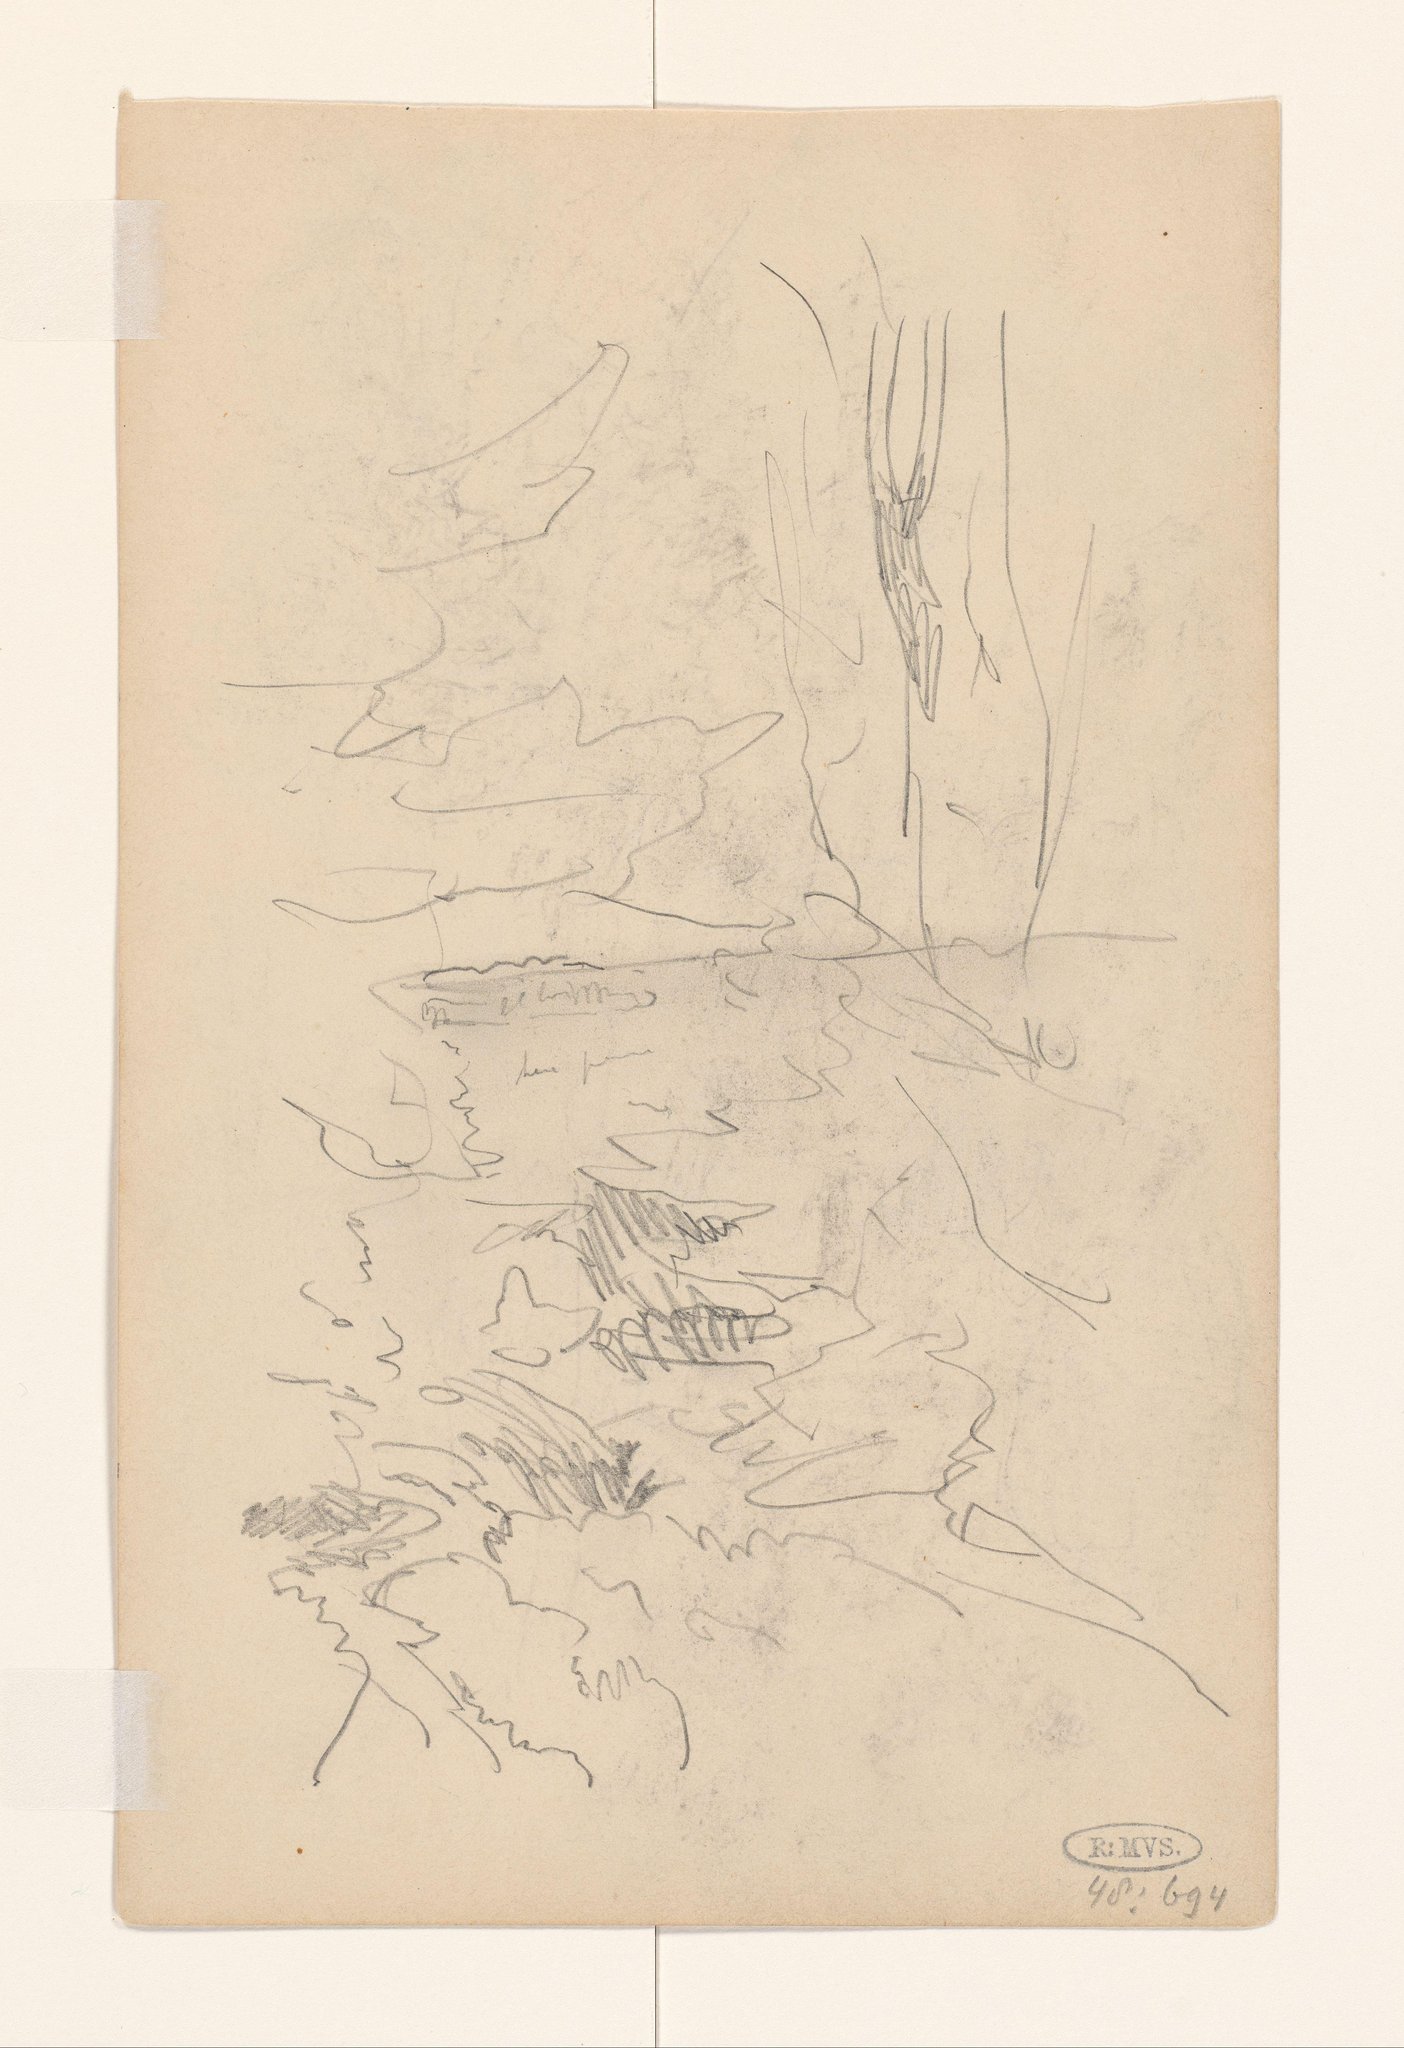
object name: drawing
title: Landschap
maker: jan hoynck van papendrecht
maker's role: draughtsman, painter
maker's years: 1858-1933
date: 1868-1933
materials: paper, pencil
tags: landscapes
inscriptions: collector's mark: Lugt 2228